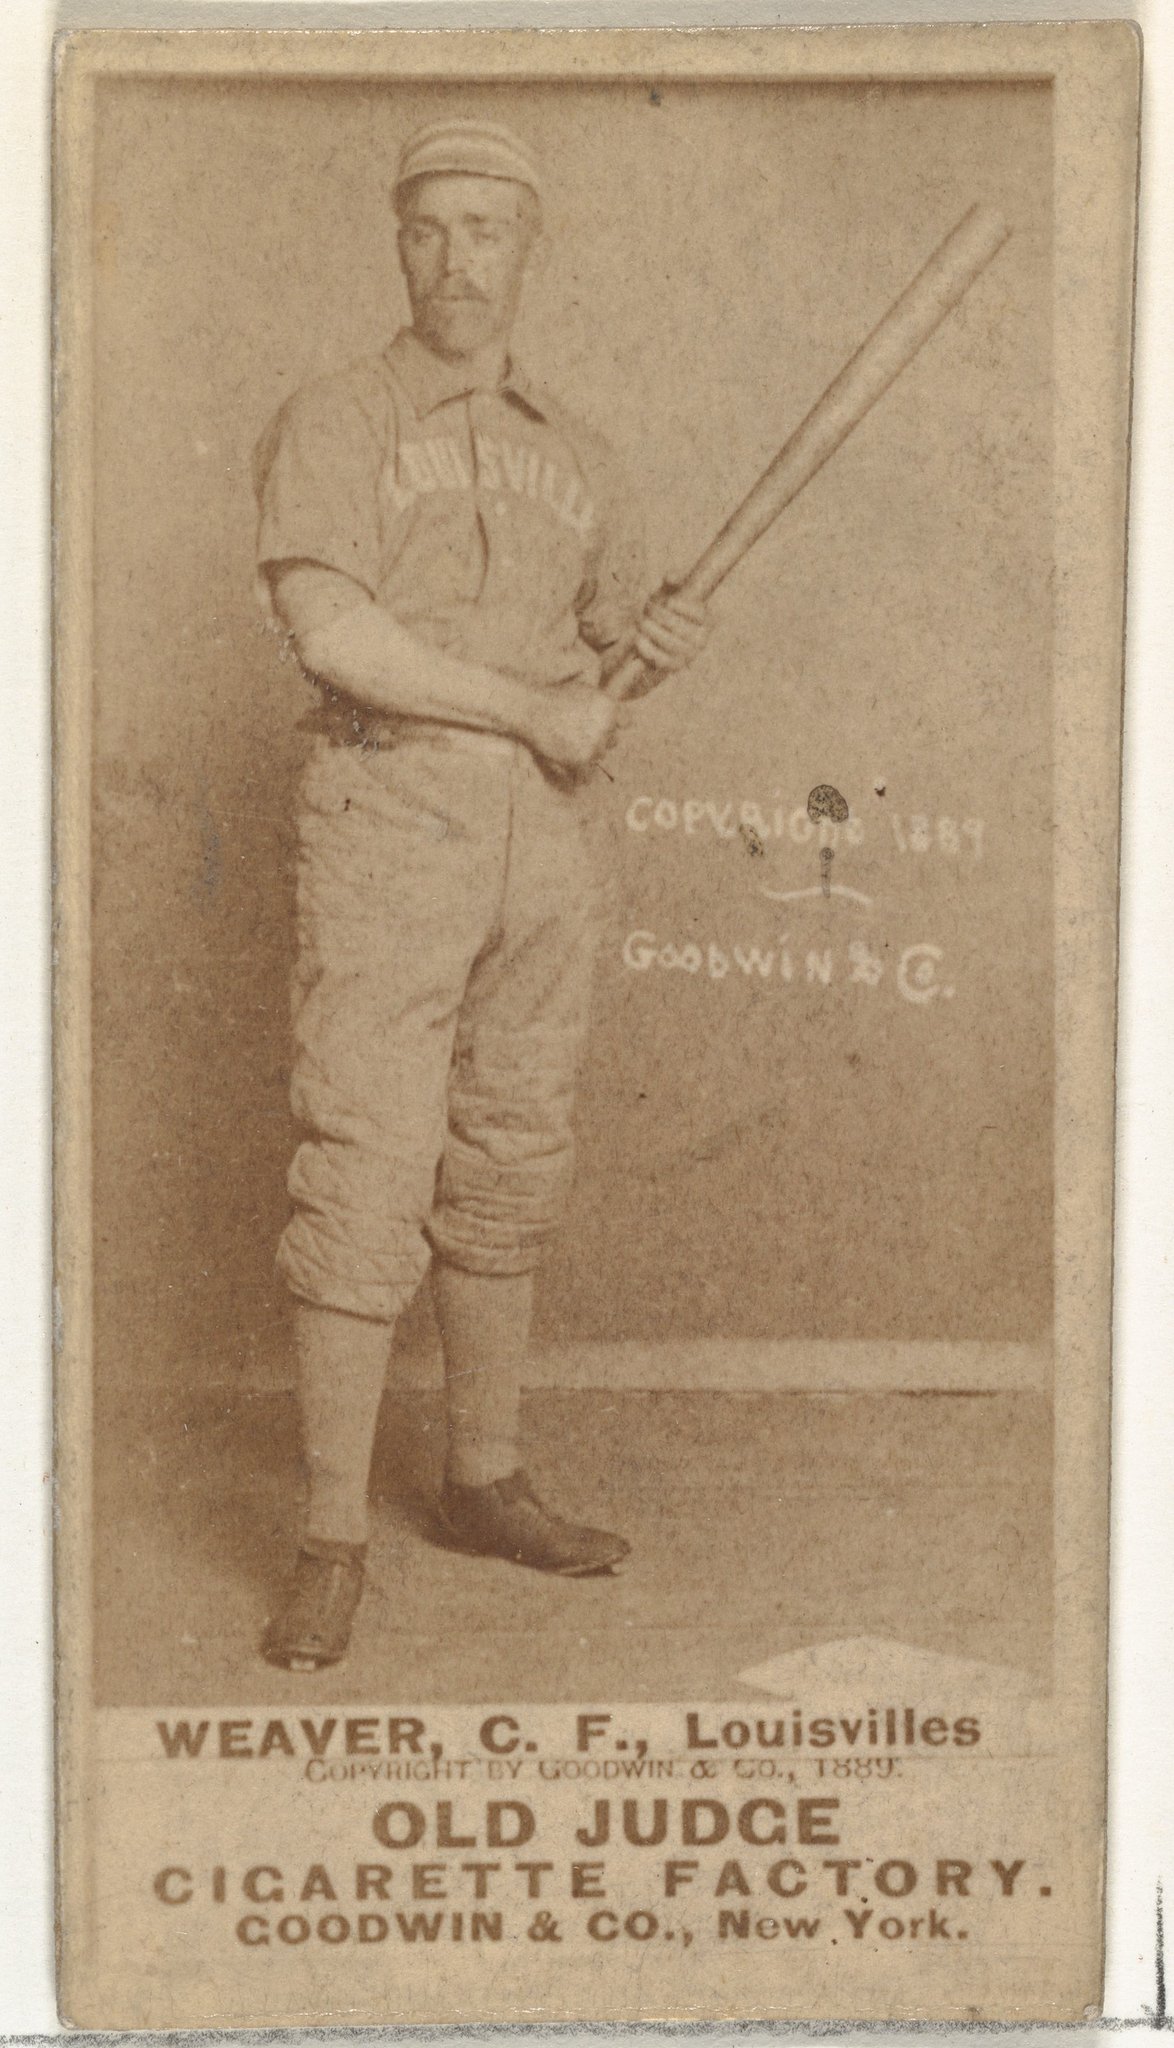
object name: baseball card, photograph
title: William B. "Farmer" Weaver, Center Field, Louisville Colonels, from the Old Judge series (N172) for Old Judge Cigarettes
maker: goodwin & company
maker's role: publisher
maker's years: 1850-1950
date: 1889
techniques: albumen silver print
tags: men,portraits,baseball,athletes